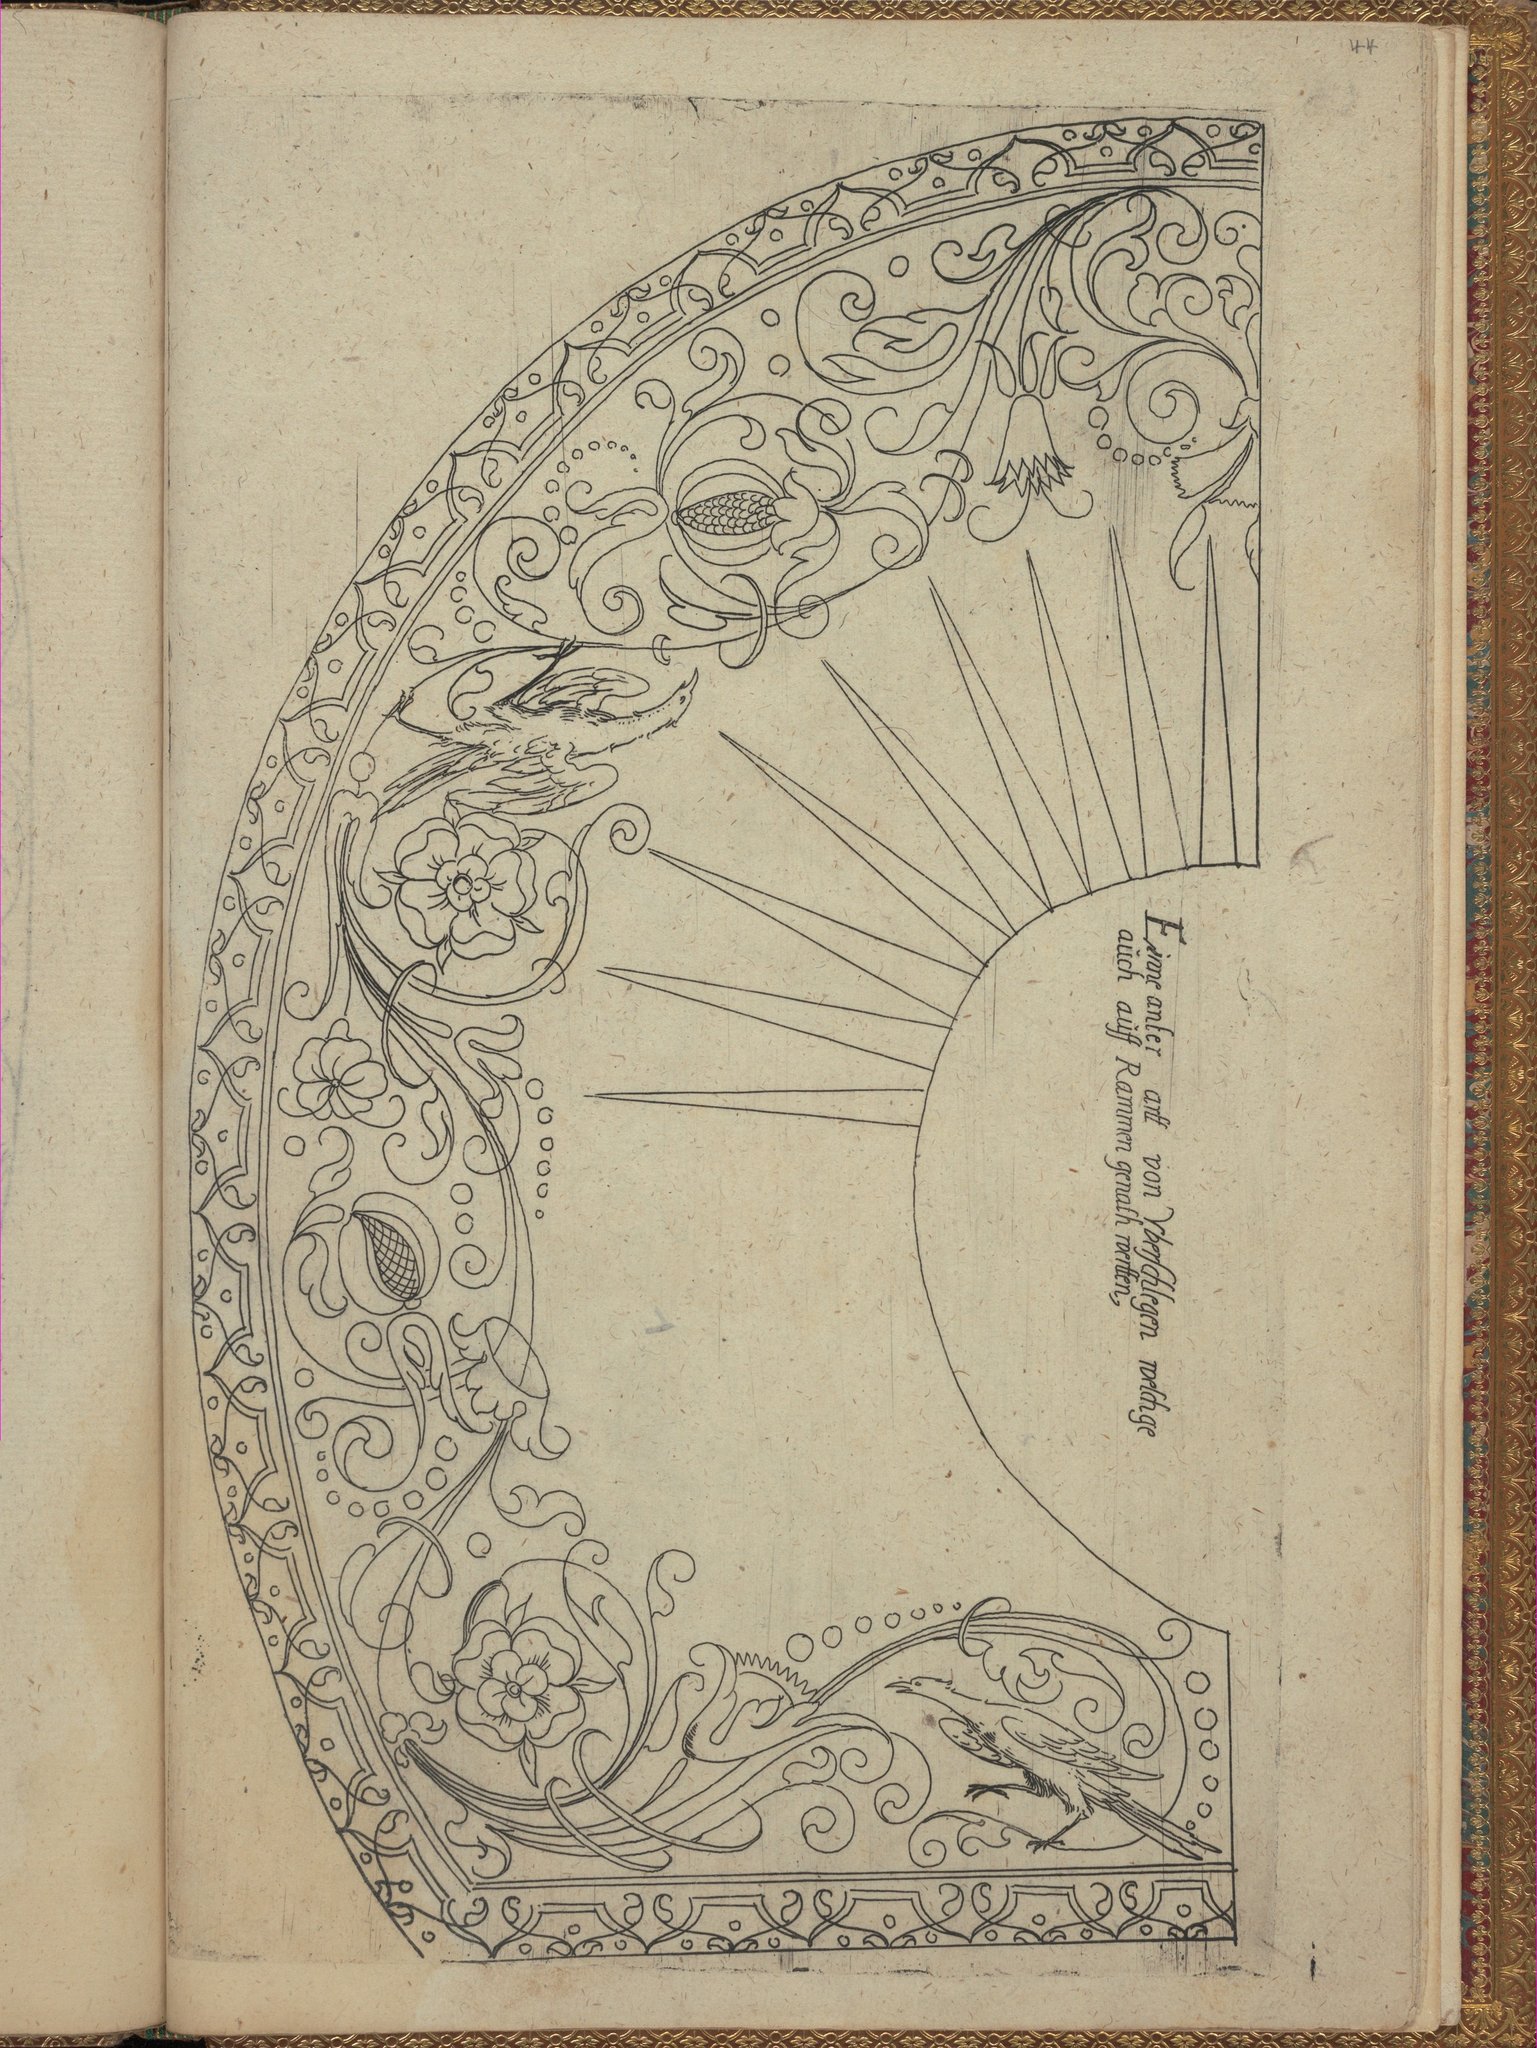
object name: book print ornament architecture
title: New Modelbüch (Page 44r)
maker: andreas bretschneider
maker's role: designer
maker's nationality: german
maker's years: 1573-1645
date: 1615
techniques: etching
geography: germany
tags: birds,flowers,vines